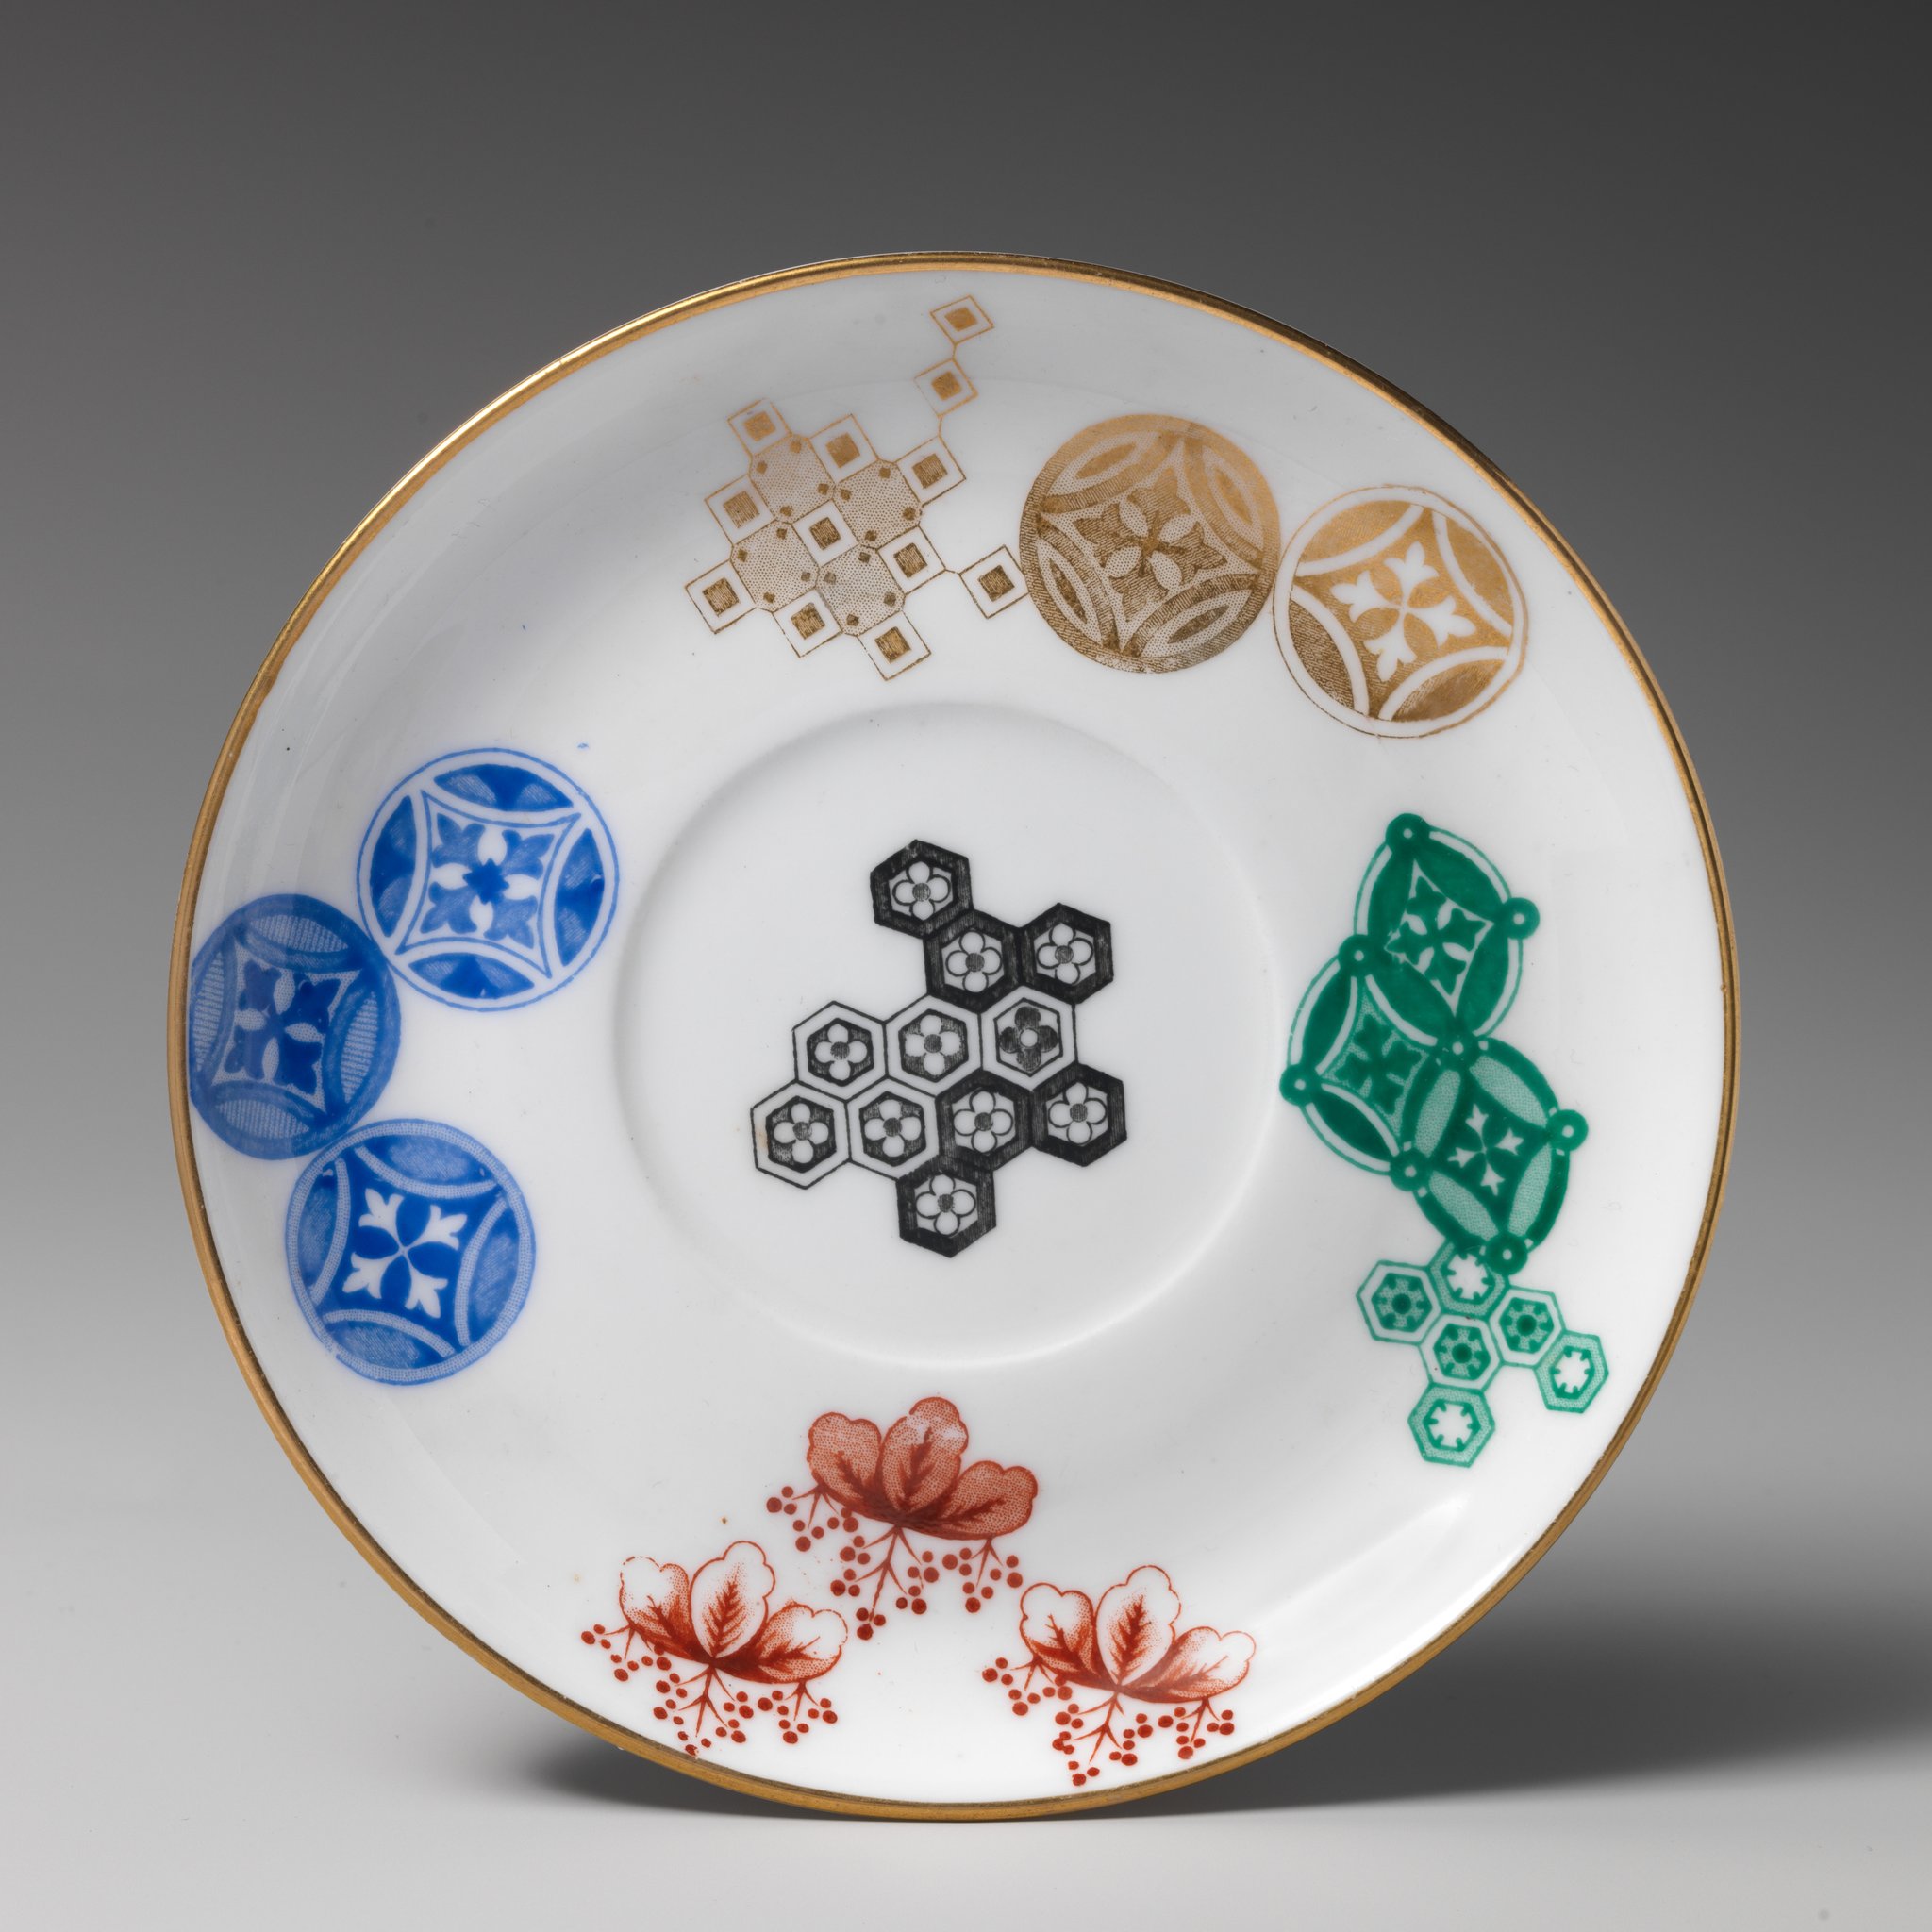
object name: saucer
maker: worcester factory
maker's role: maker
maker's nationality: british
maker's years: 1751-2008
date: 1876-1877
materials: bone china